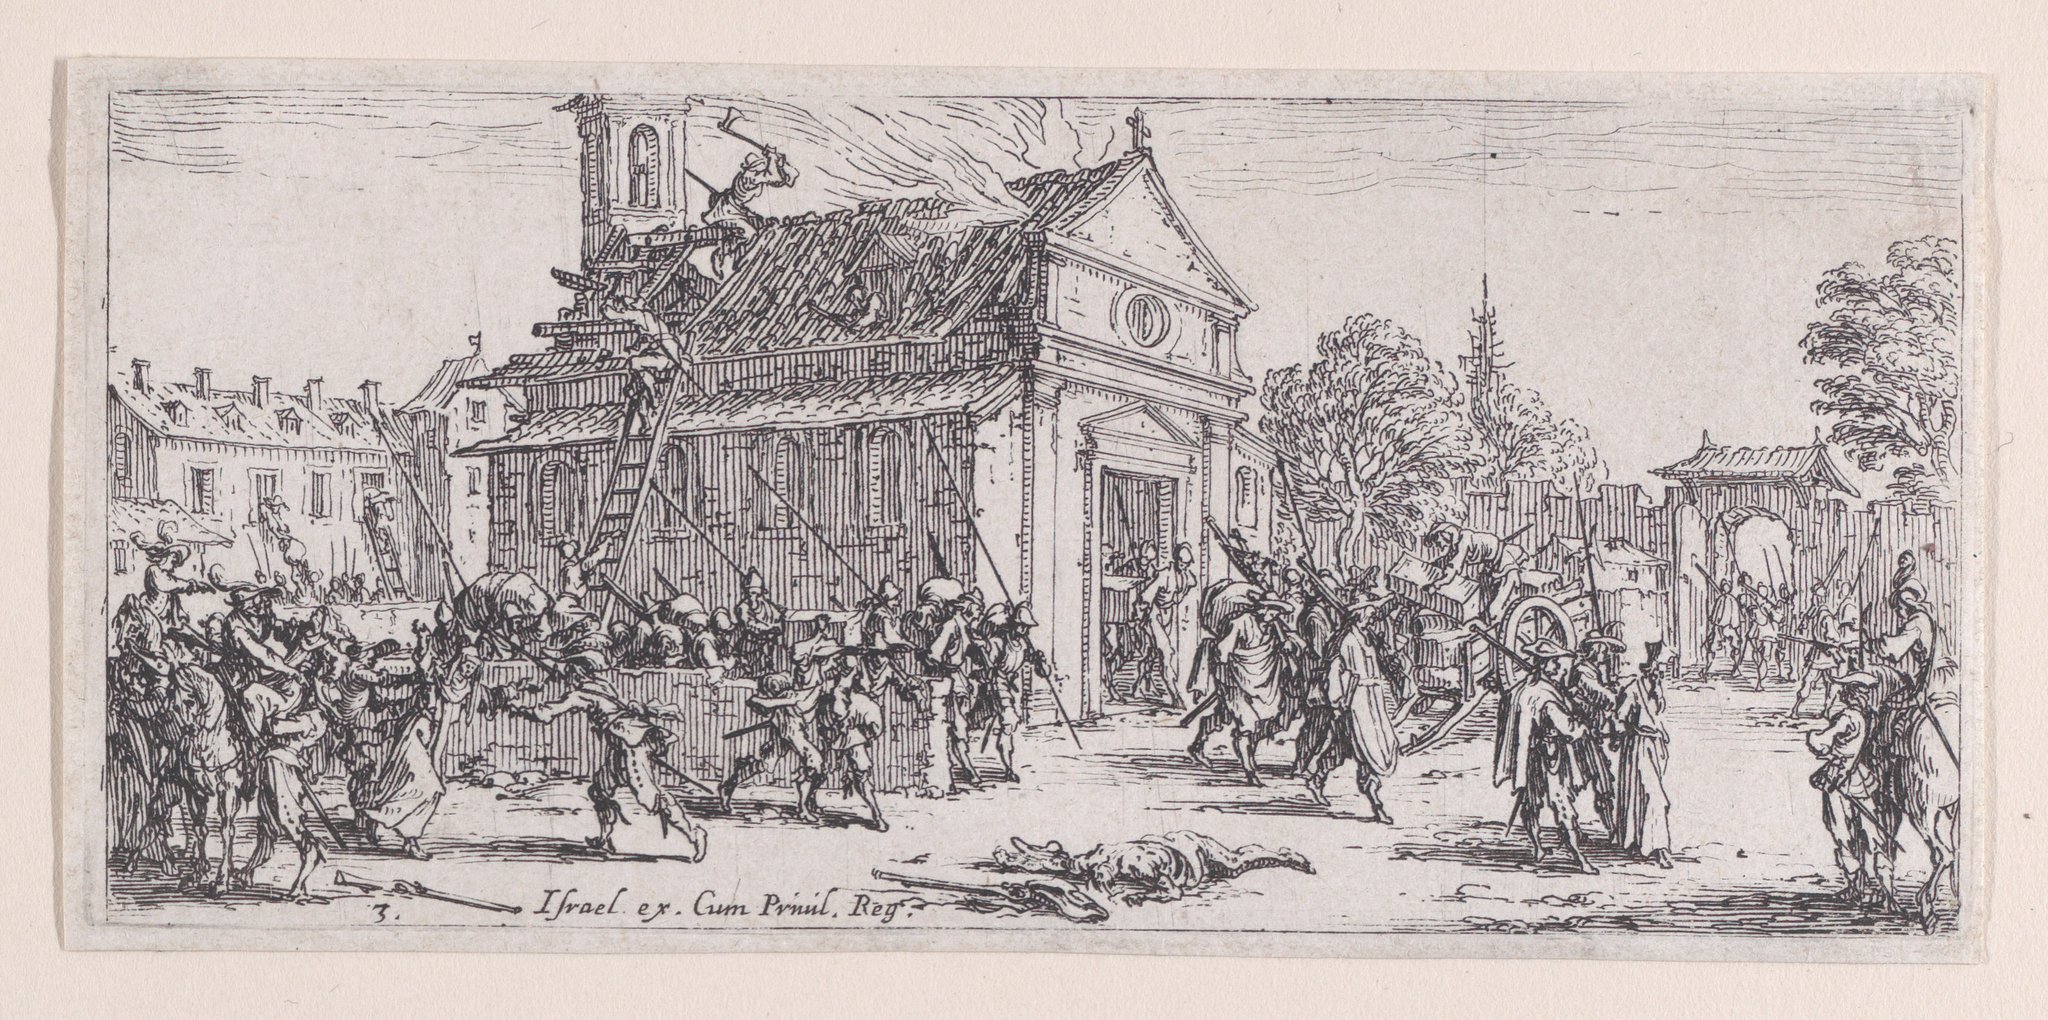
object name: print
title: Dévastation d'un Monastère (Devastation of a Monastery), plate 3 from "Les Petites Misères de la Guerre" (The Little Miseries of War)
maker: jacques callot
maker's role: artist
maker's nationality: french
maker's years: 1592-1635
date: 1636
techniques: etching